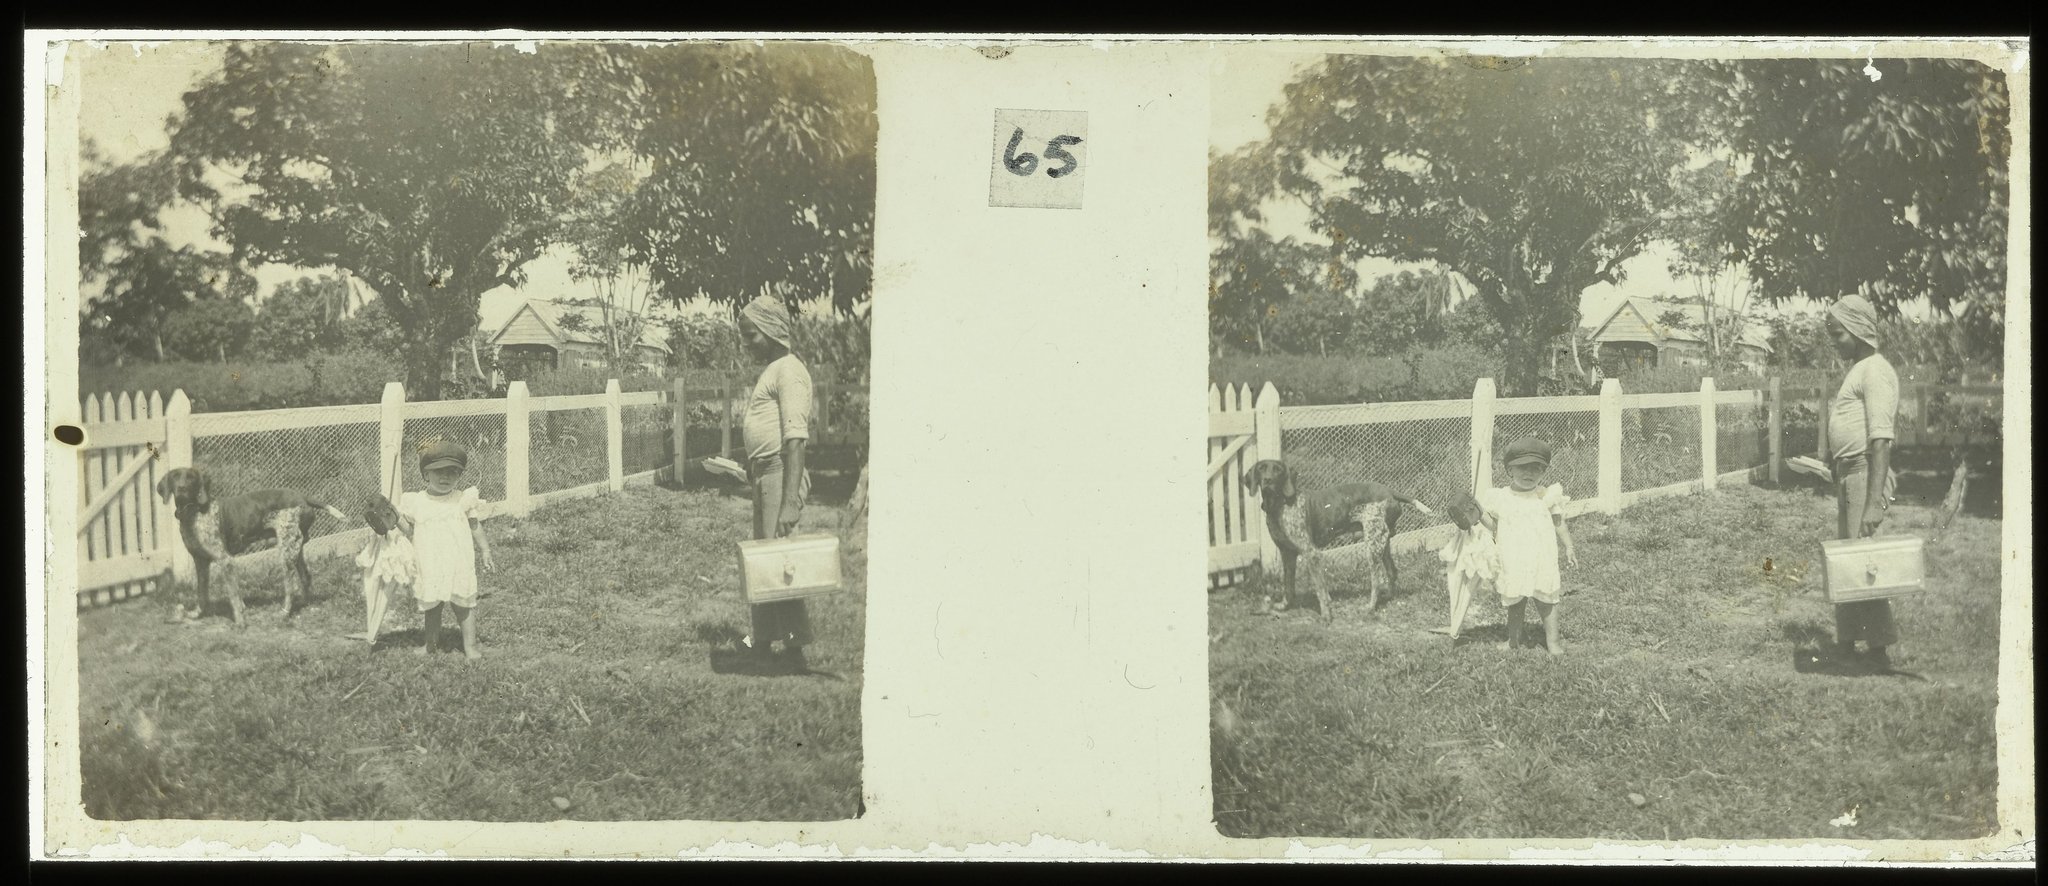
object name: stereograph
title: Postbode bij plantage Accaribo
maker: theodoor brouwers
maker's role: amateurfotograaf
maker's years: 1874-1932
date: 1913-1930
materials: glass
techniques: photography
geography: suriname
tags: amsterdam, theodoor brouwers, plantation, suriname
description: In de periode 1911-1932 woonde op plantage Accaribo in Suriname de familie Brouwers van wie de foto's afkomstig zijn. Rond 1910 vond Theodoor Brouwers werk op plantage Accaribo. In 1929 werd hij eigenaar van de plantage. Op Accaribo werden in zijn tijd bananen geproduceerd en wat koffie.